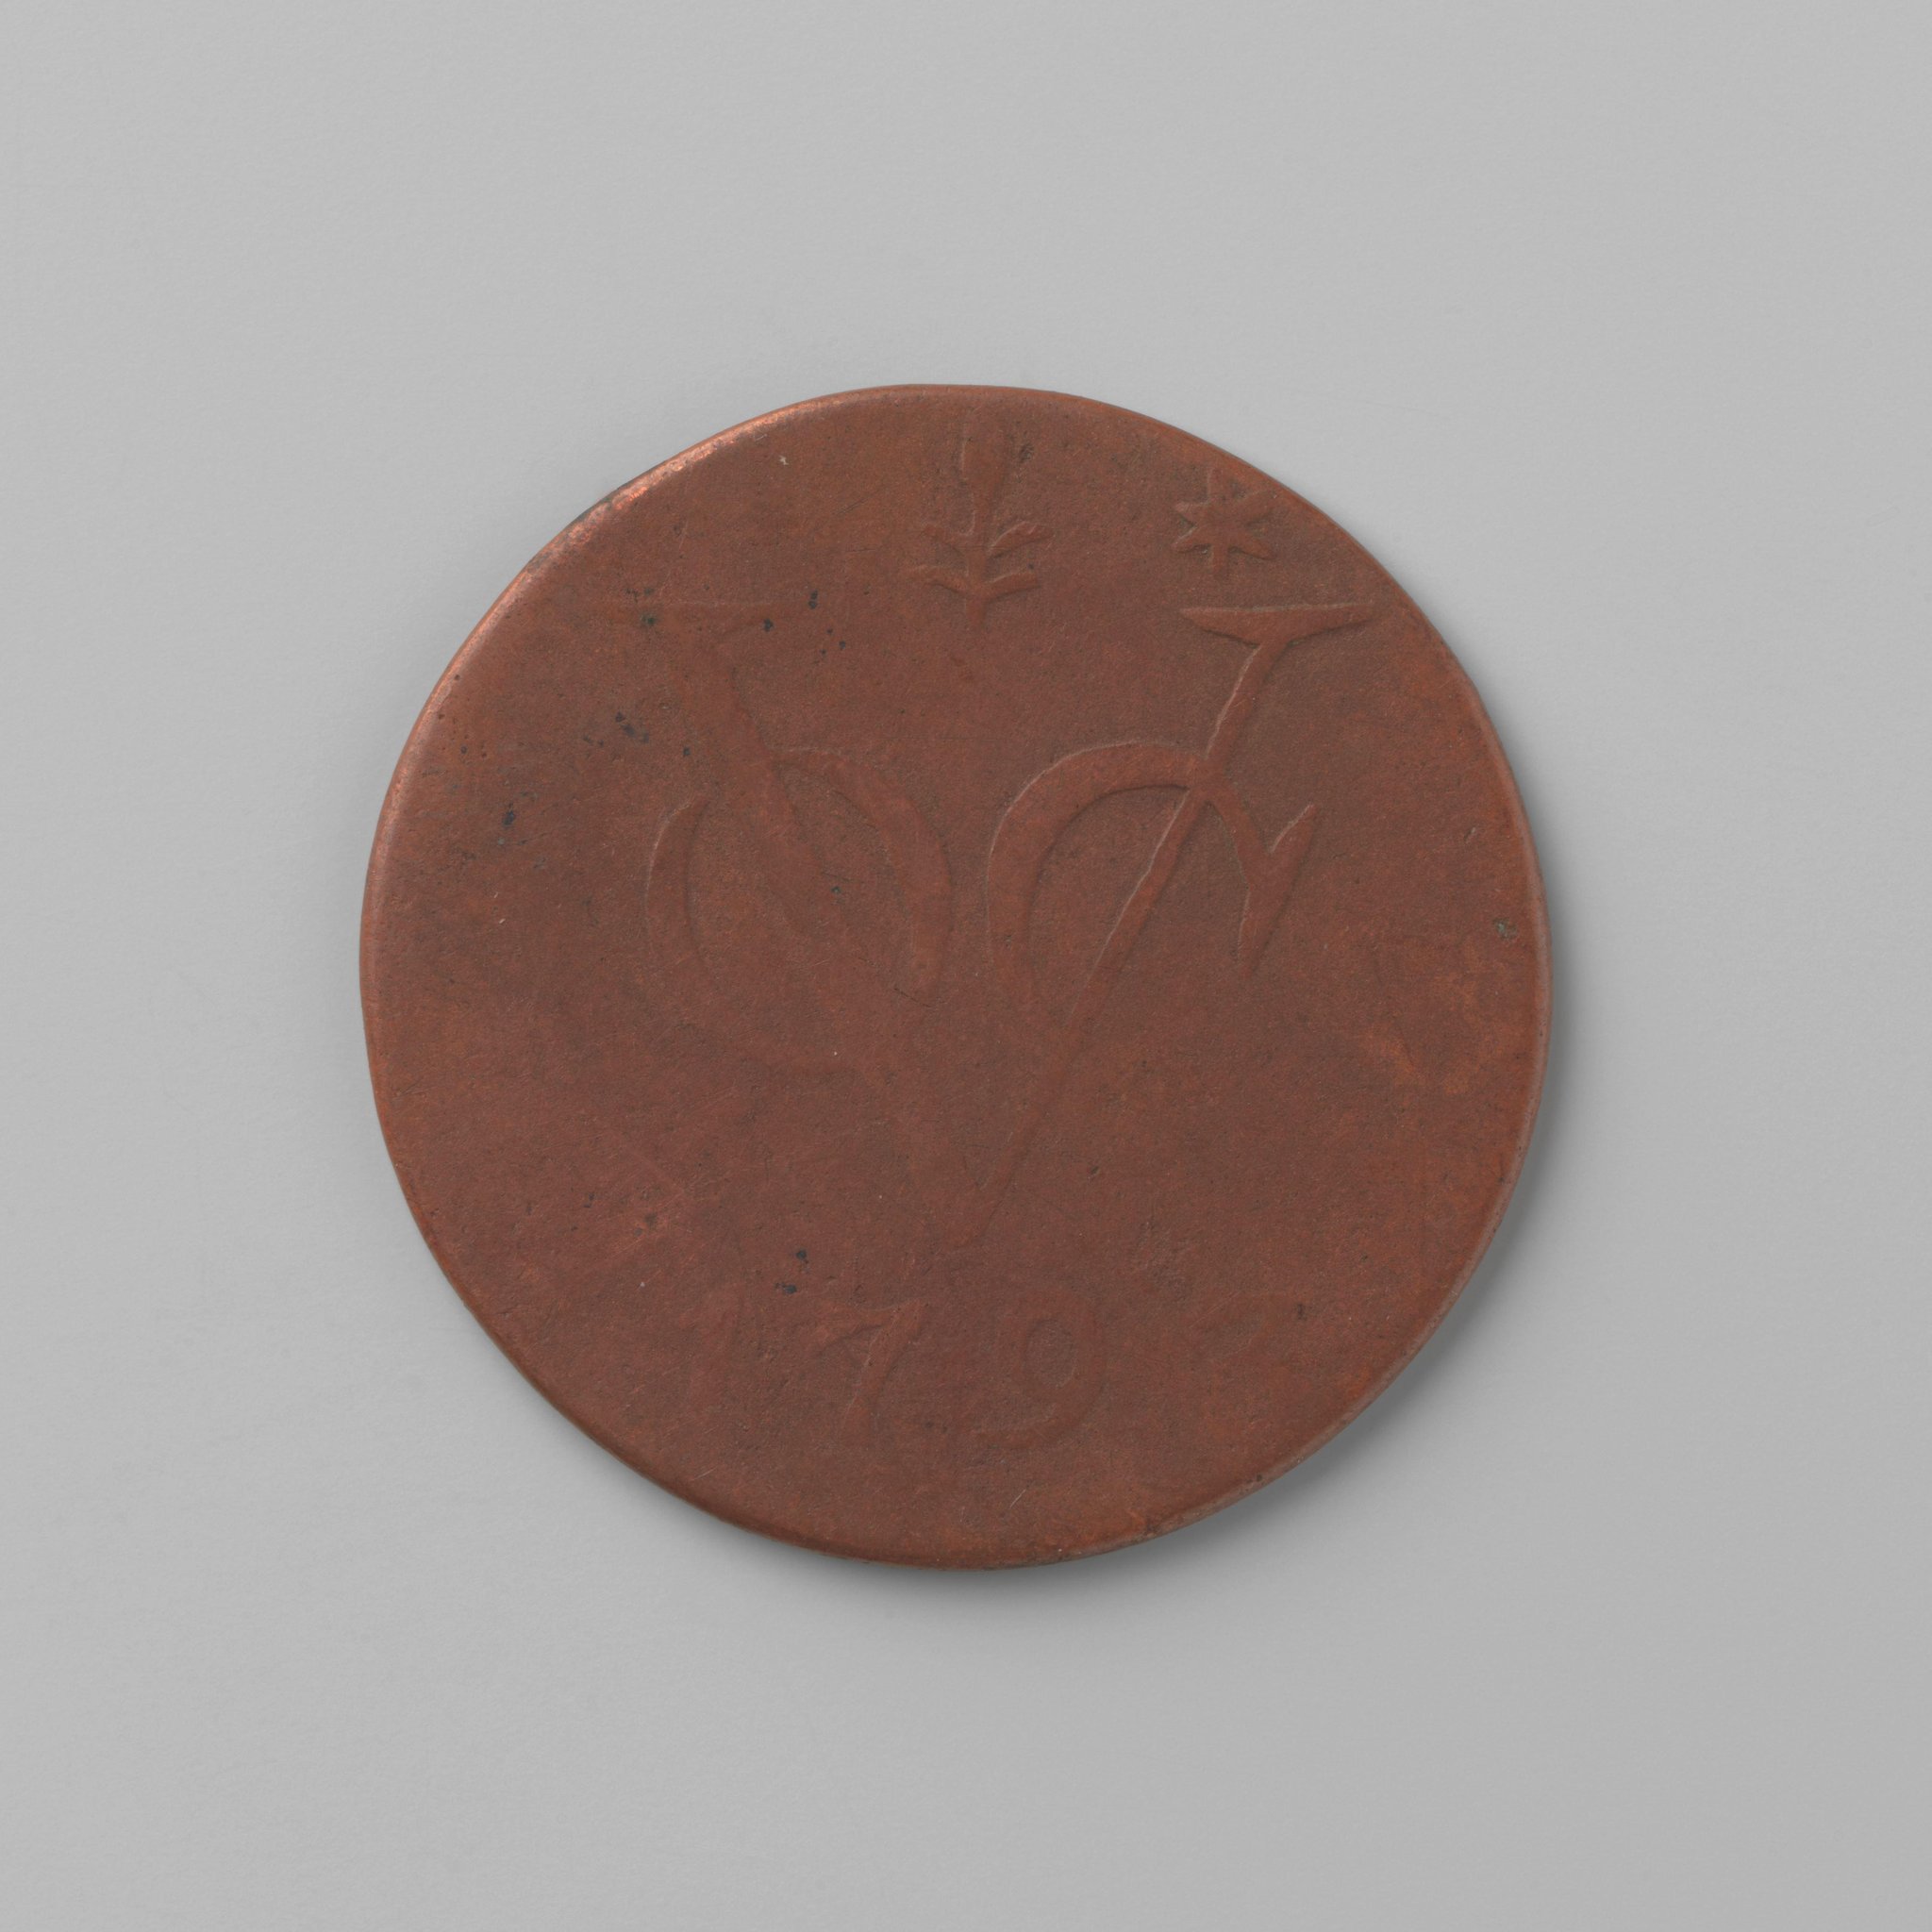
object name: coin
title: Duit van de VOC uit Gelderland,1793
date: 1793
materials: copper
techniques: striking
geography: harderwijk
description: Koperen munt. Voorzijde: tussen wapenspreuk gekroond wapenschild van Gelderland. Keerzijde: monogram van de VOC, waarboven muntmeesterteken en waaronder jaartal. Gladde rand.